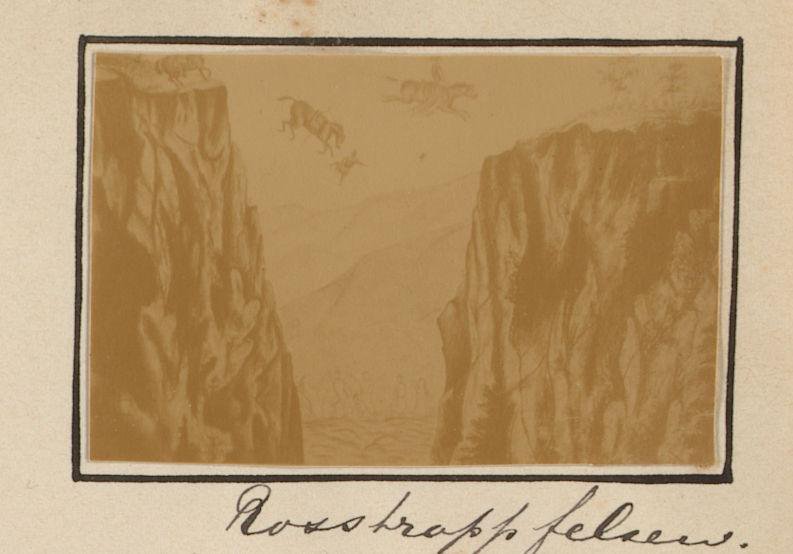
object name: photograph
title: Fotoreproductie van een prent van paarden die over een kloof springen waarbij een paard en ruiter in het ravijn vallen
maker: Anonymous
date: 1860-1891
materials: photographic support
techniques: albumen print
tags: ravine, chasm, abyss, canyon, horse, germany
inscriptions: annotation: ‘Rosstrappfelsen’, annotation: ‘Rosstrappe/ Gezicht op [...] en/ (...)’